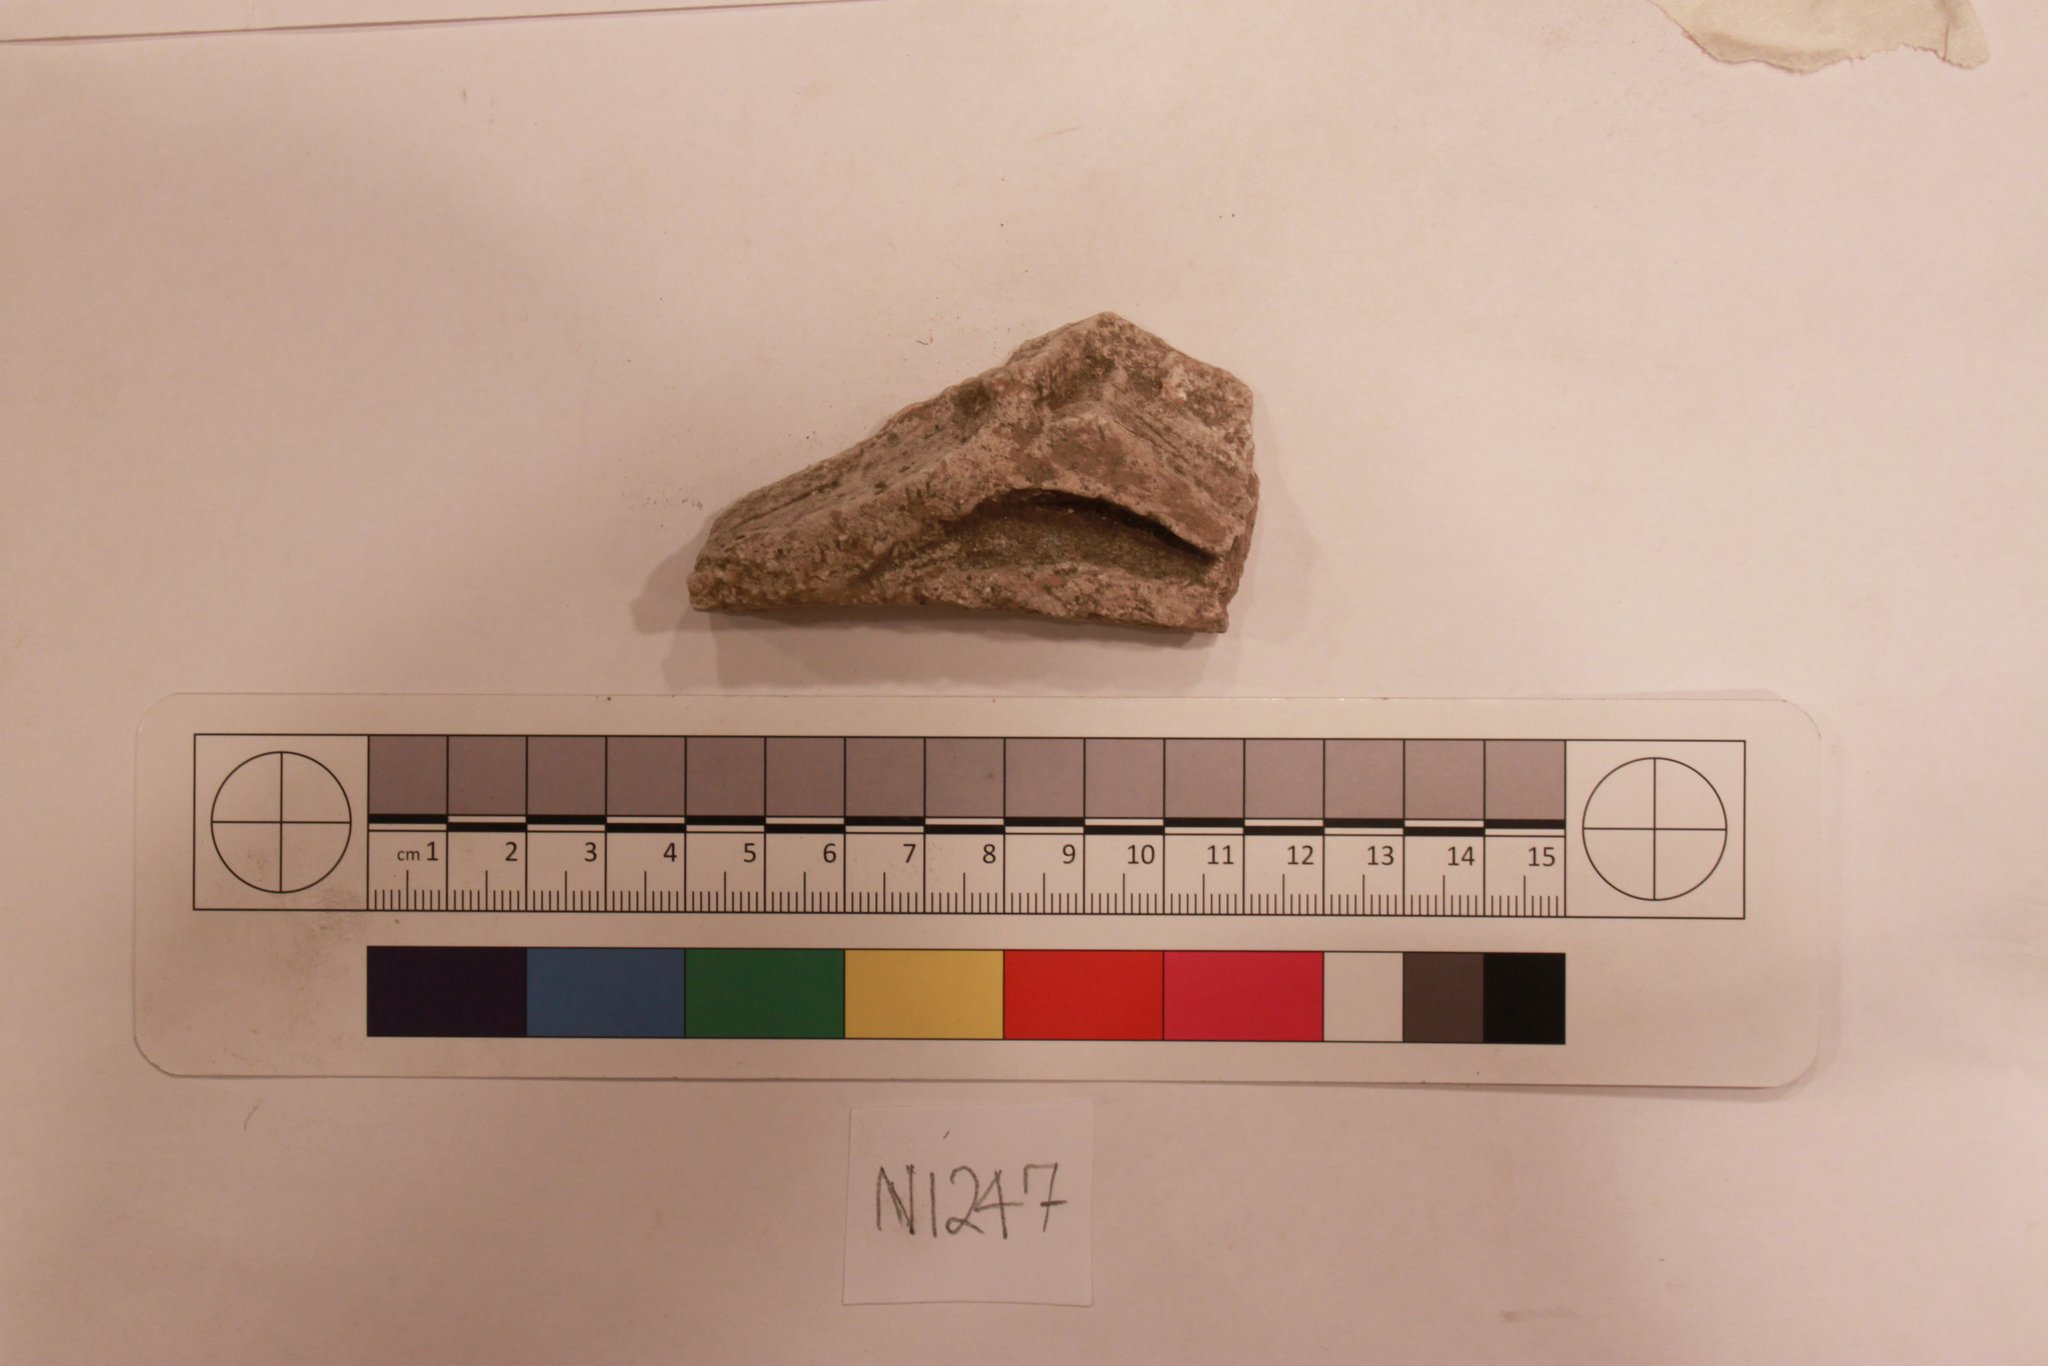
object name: fragment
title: Stucco Fragment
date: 701-1200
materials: plaster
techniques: carving, painting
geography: iran